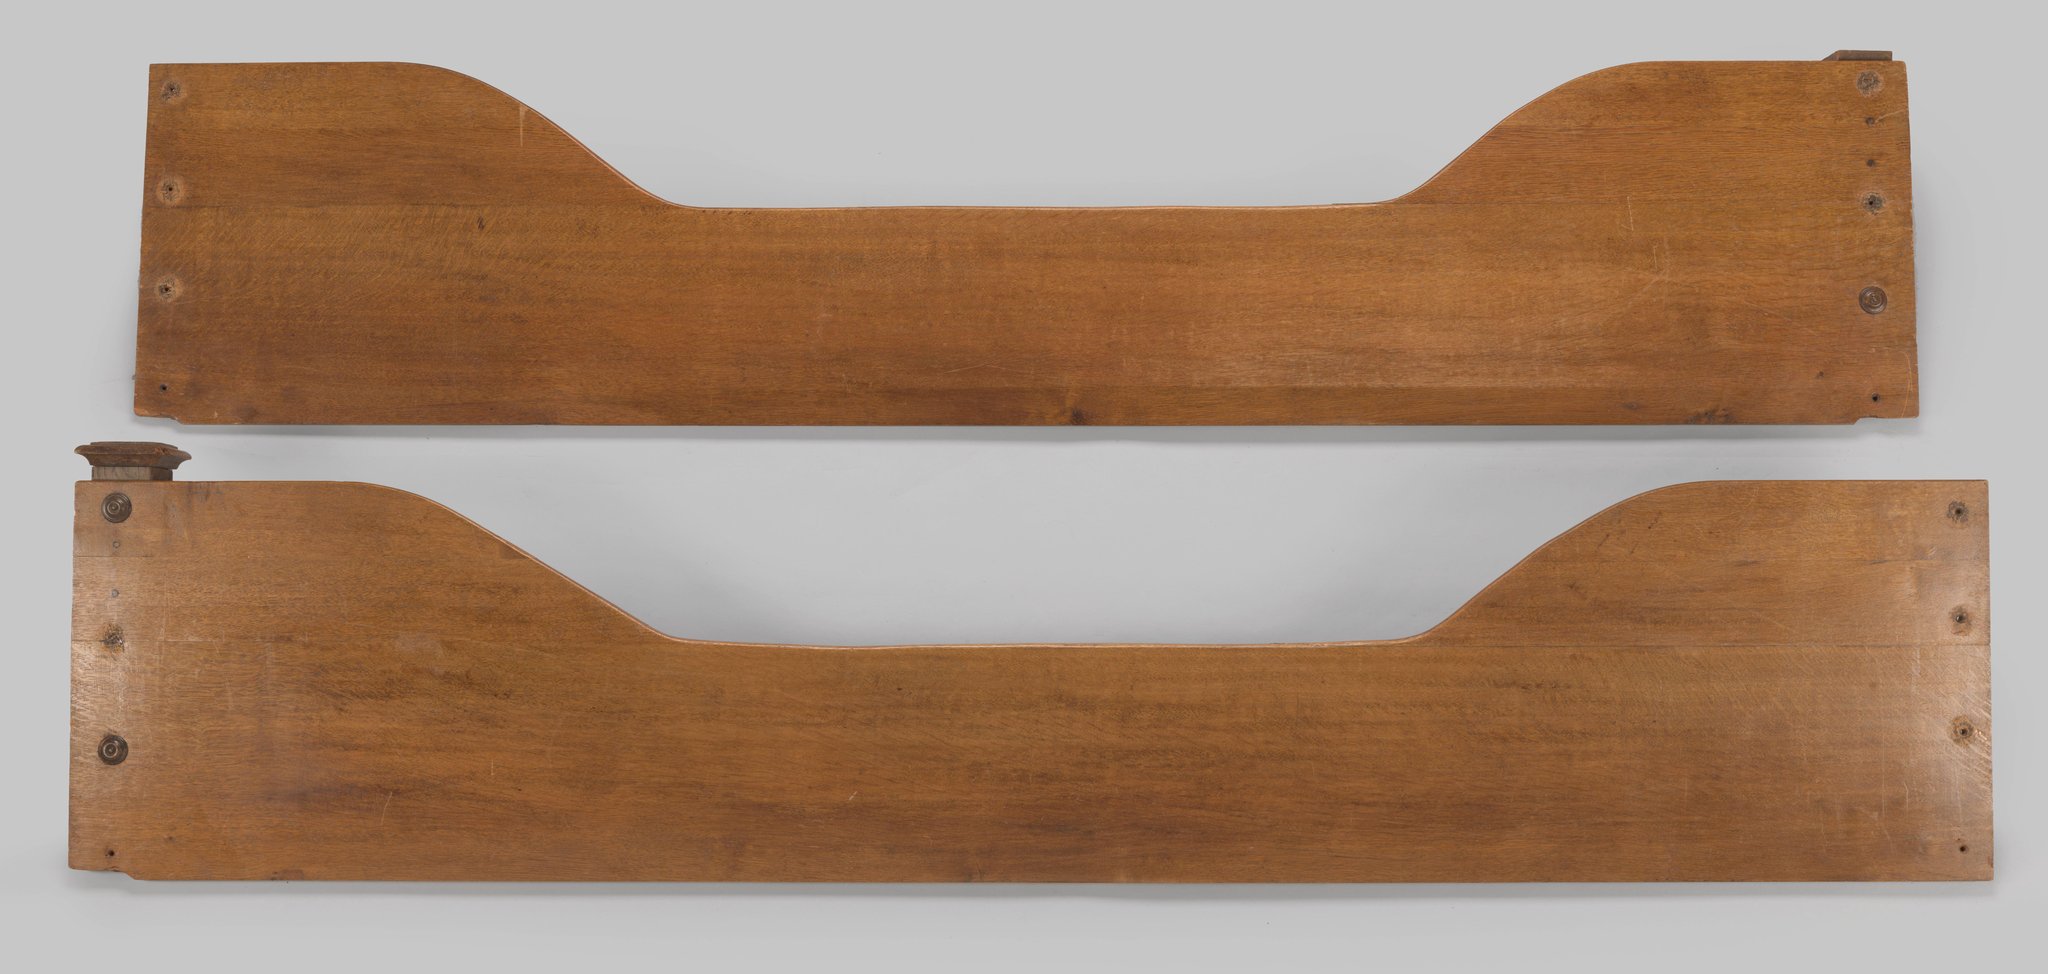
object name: canopy bed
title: Four-poster bed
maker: Anonymous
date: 1715-1720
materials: wood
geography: netherlands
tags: ornament derived from plant forms